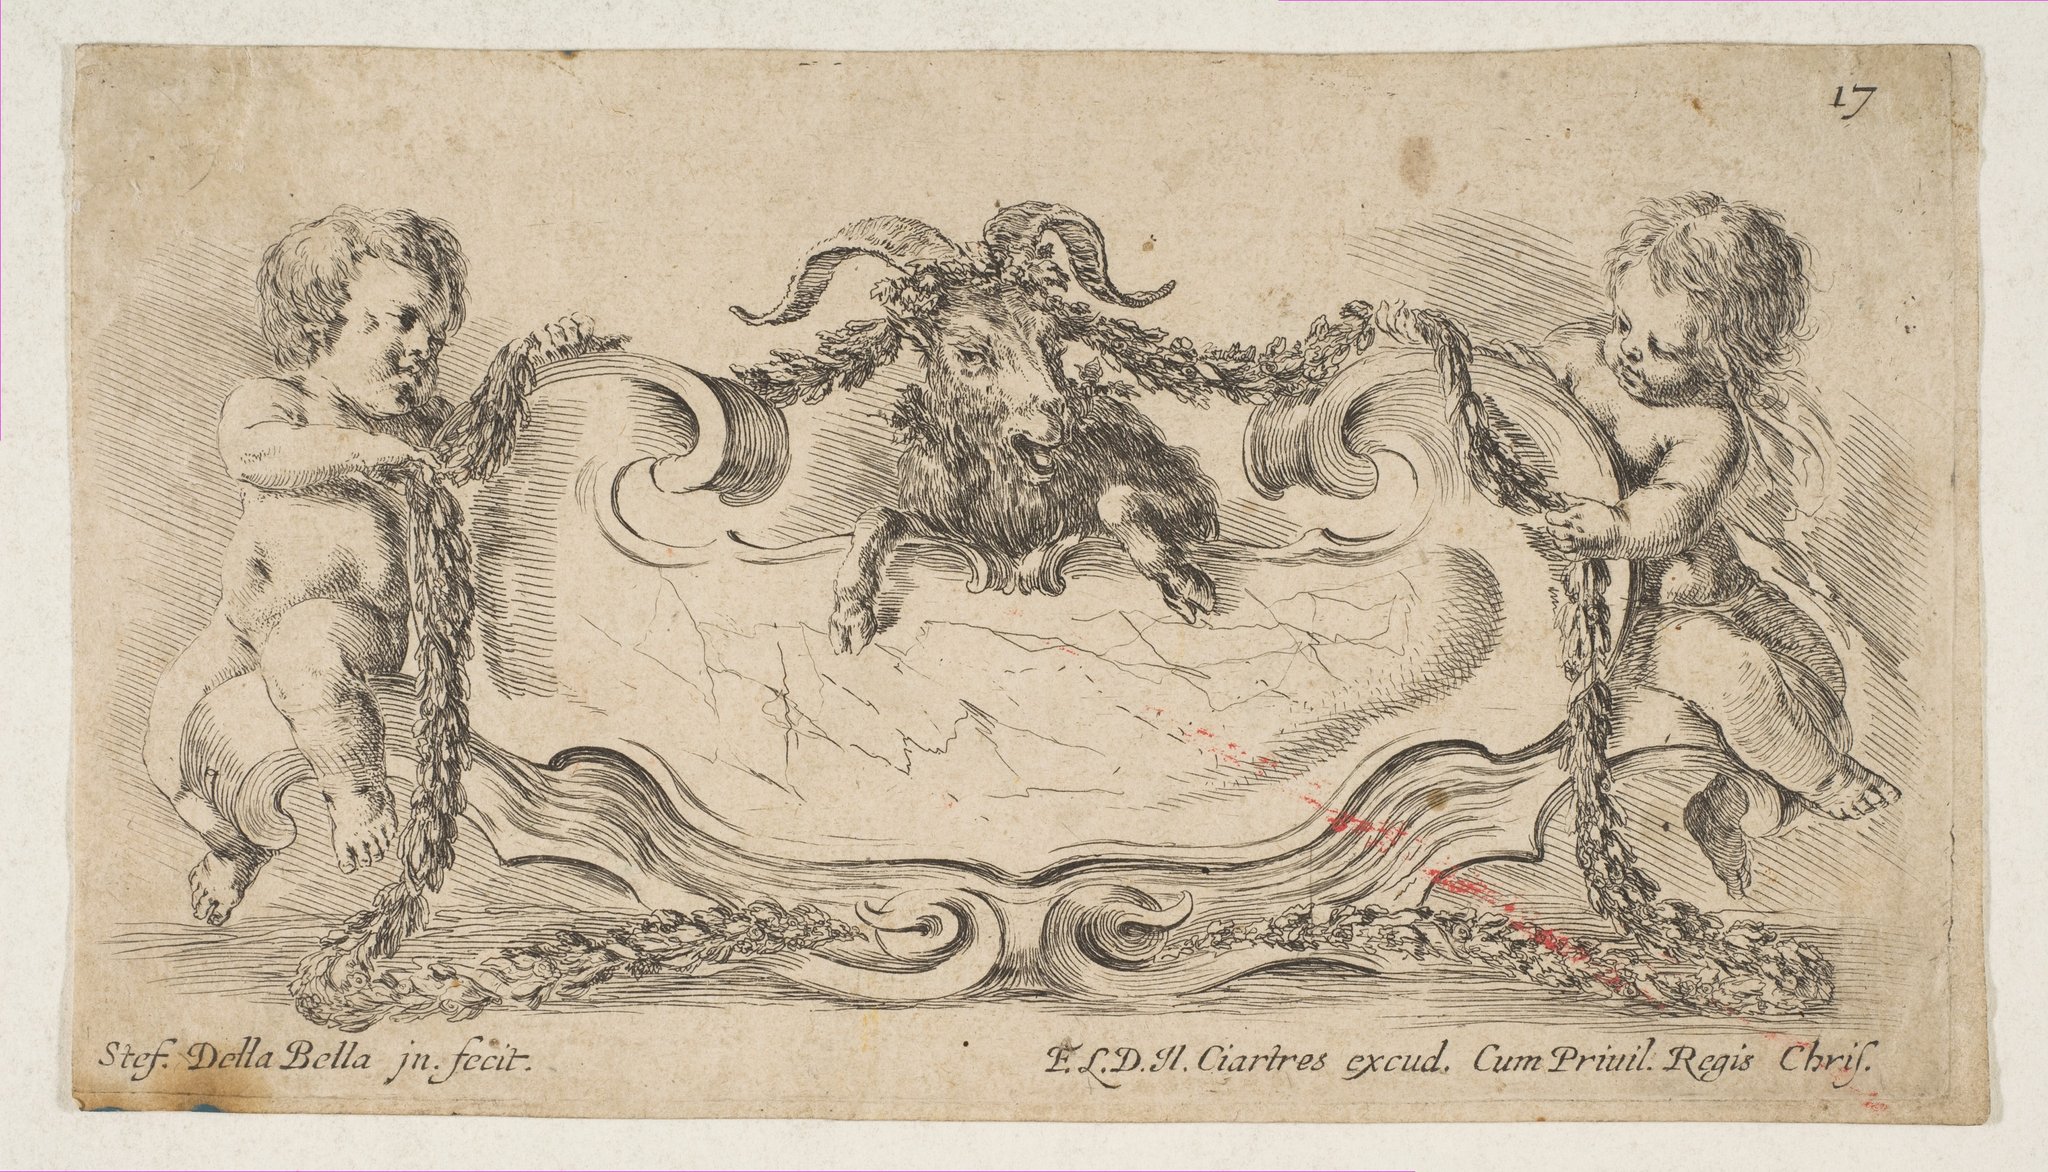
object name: print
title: Cartouche Framed by Children and a Goat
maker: stefano della bella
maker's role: artist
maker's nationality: italian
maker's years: 1610-1664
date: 1646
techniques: etching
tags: cartouches,children,goats